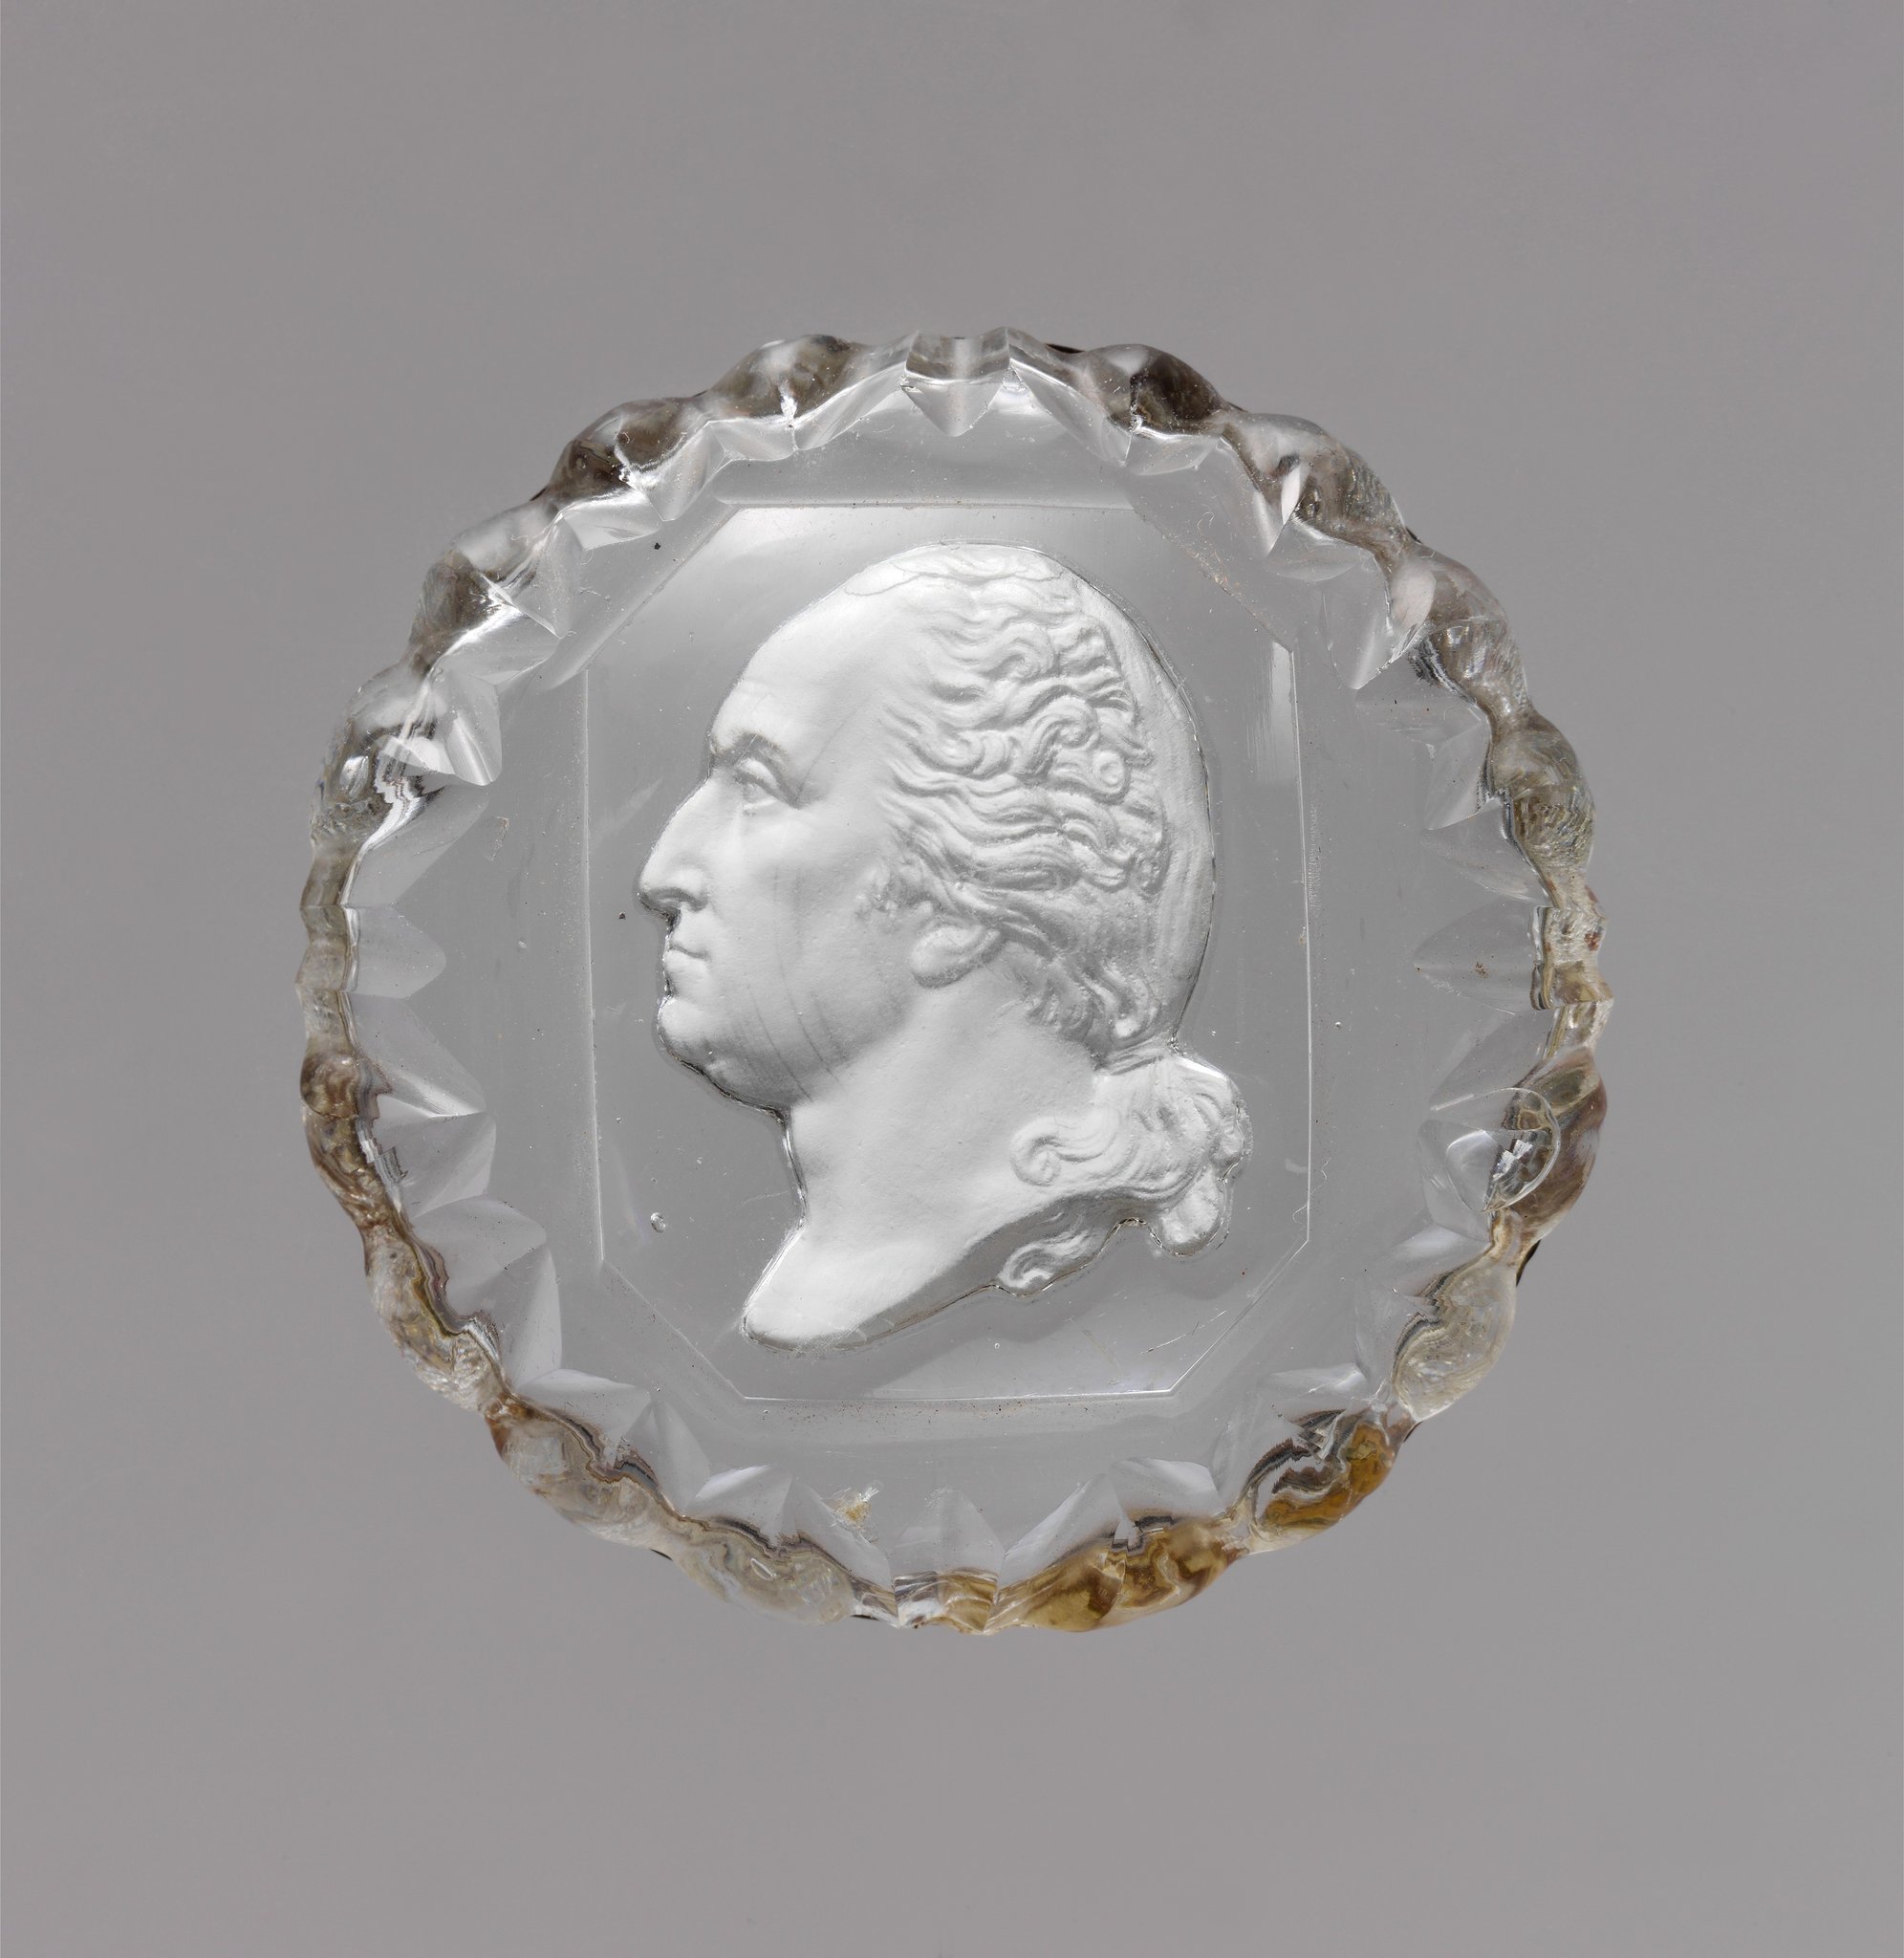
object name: bust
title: George Washington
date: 1825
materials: ceramic, glass, paste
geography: england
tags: george washington,profiles